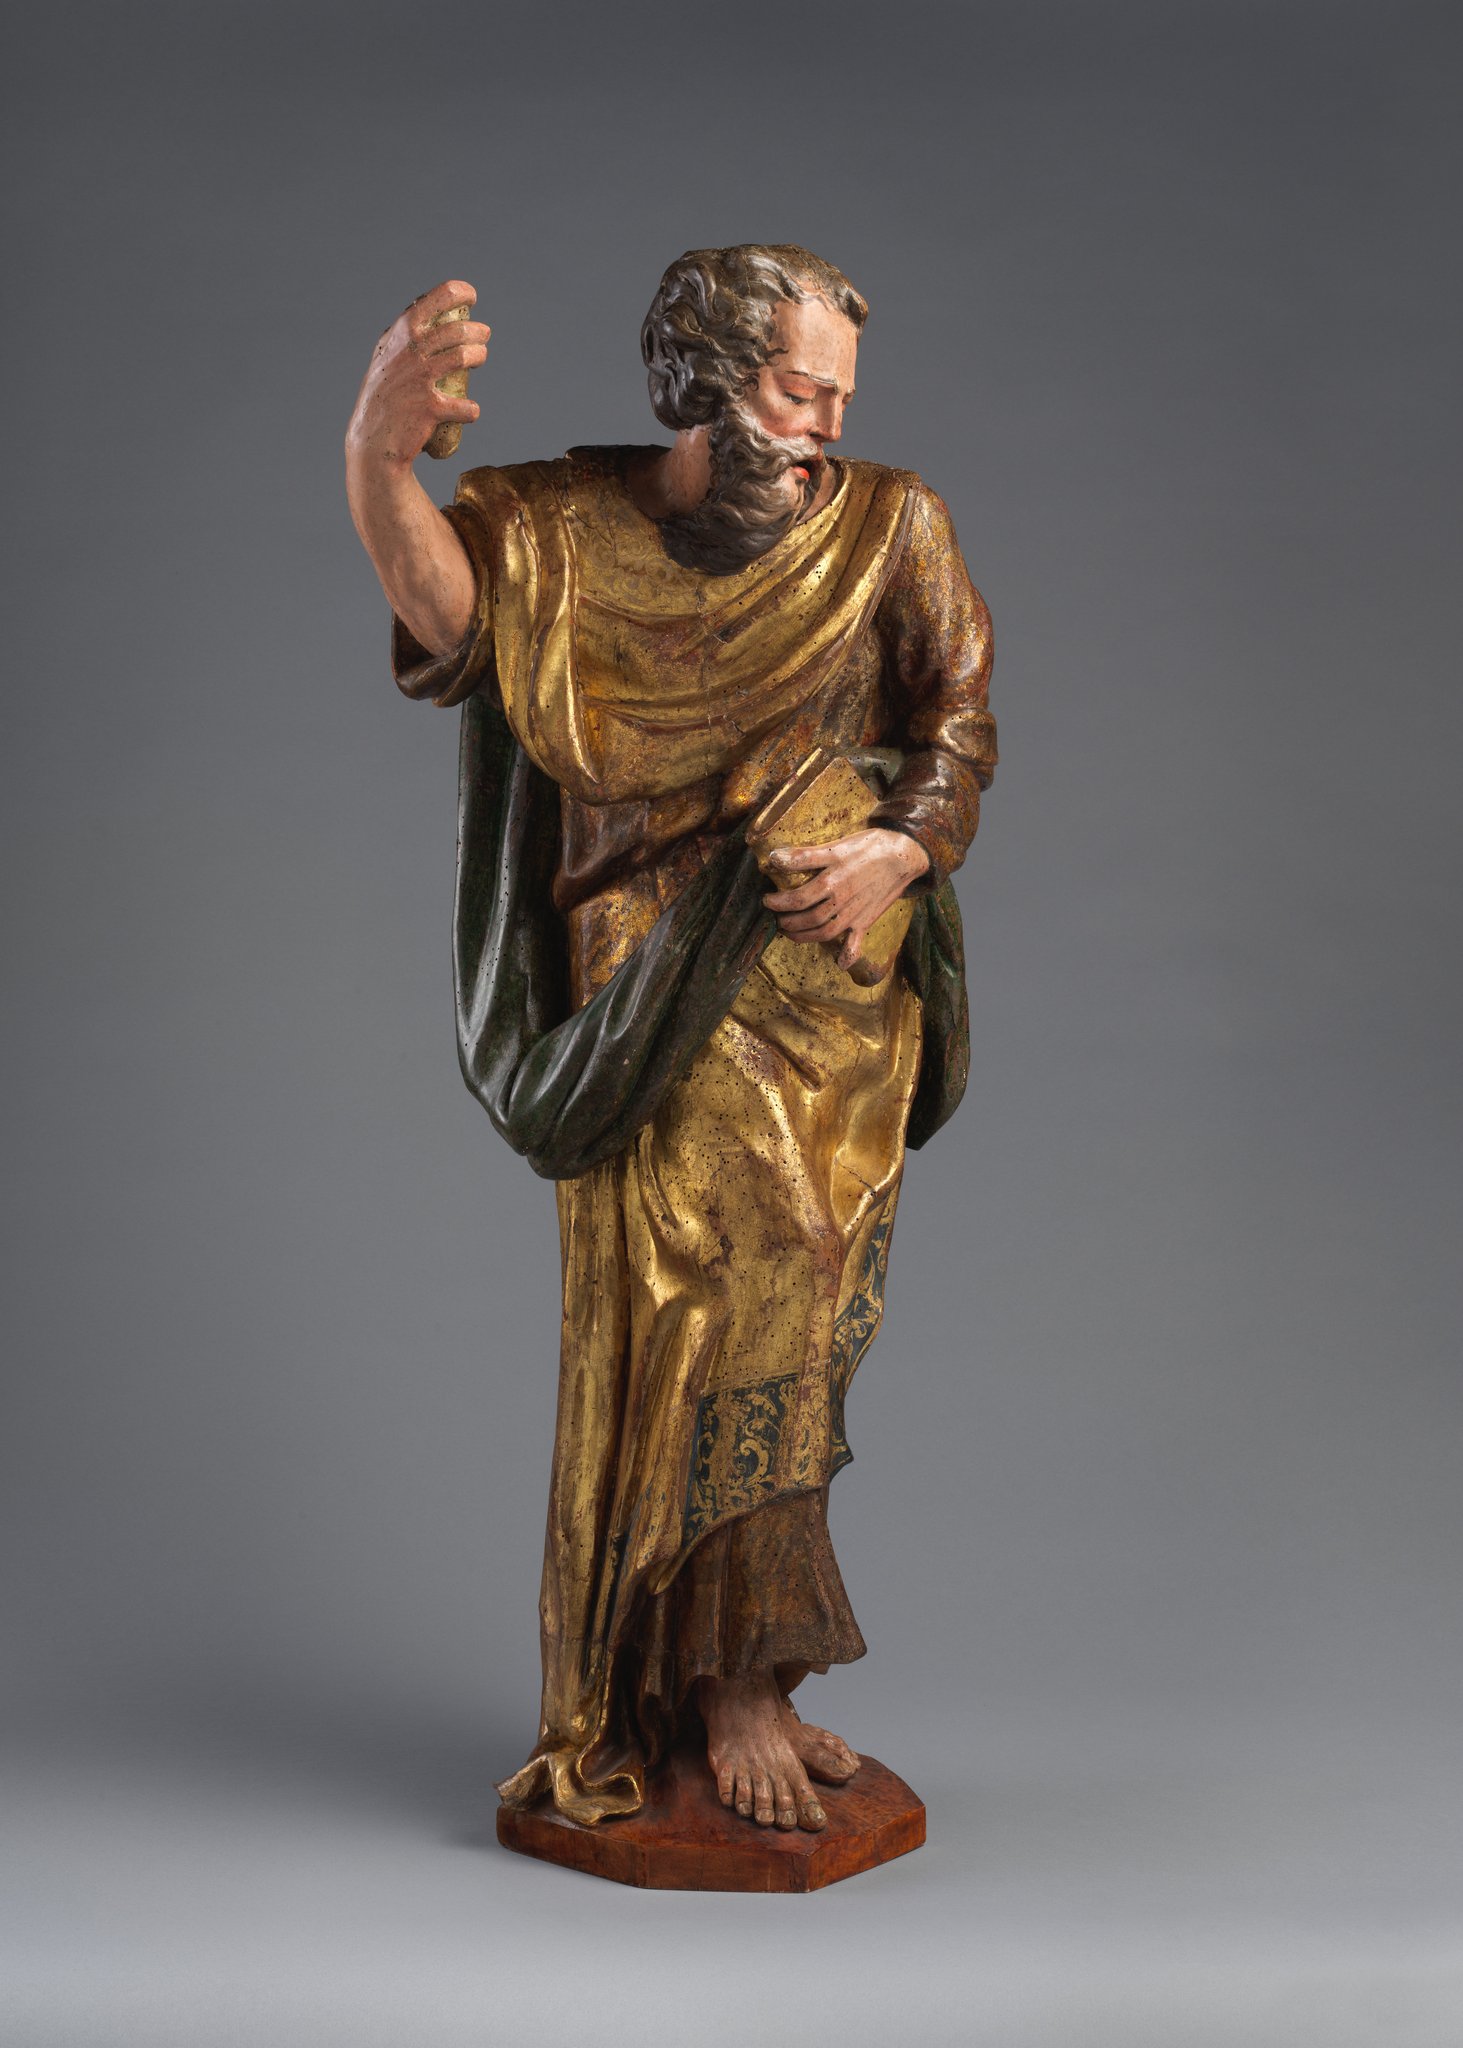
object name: figure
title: Apostle or Saint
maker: alonso berruguete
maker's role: artist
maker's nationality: spanish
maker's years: 1488-1561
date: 1520-1529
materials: gilt, wood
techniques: polychrome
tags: men,apostles,saints